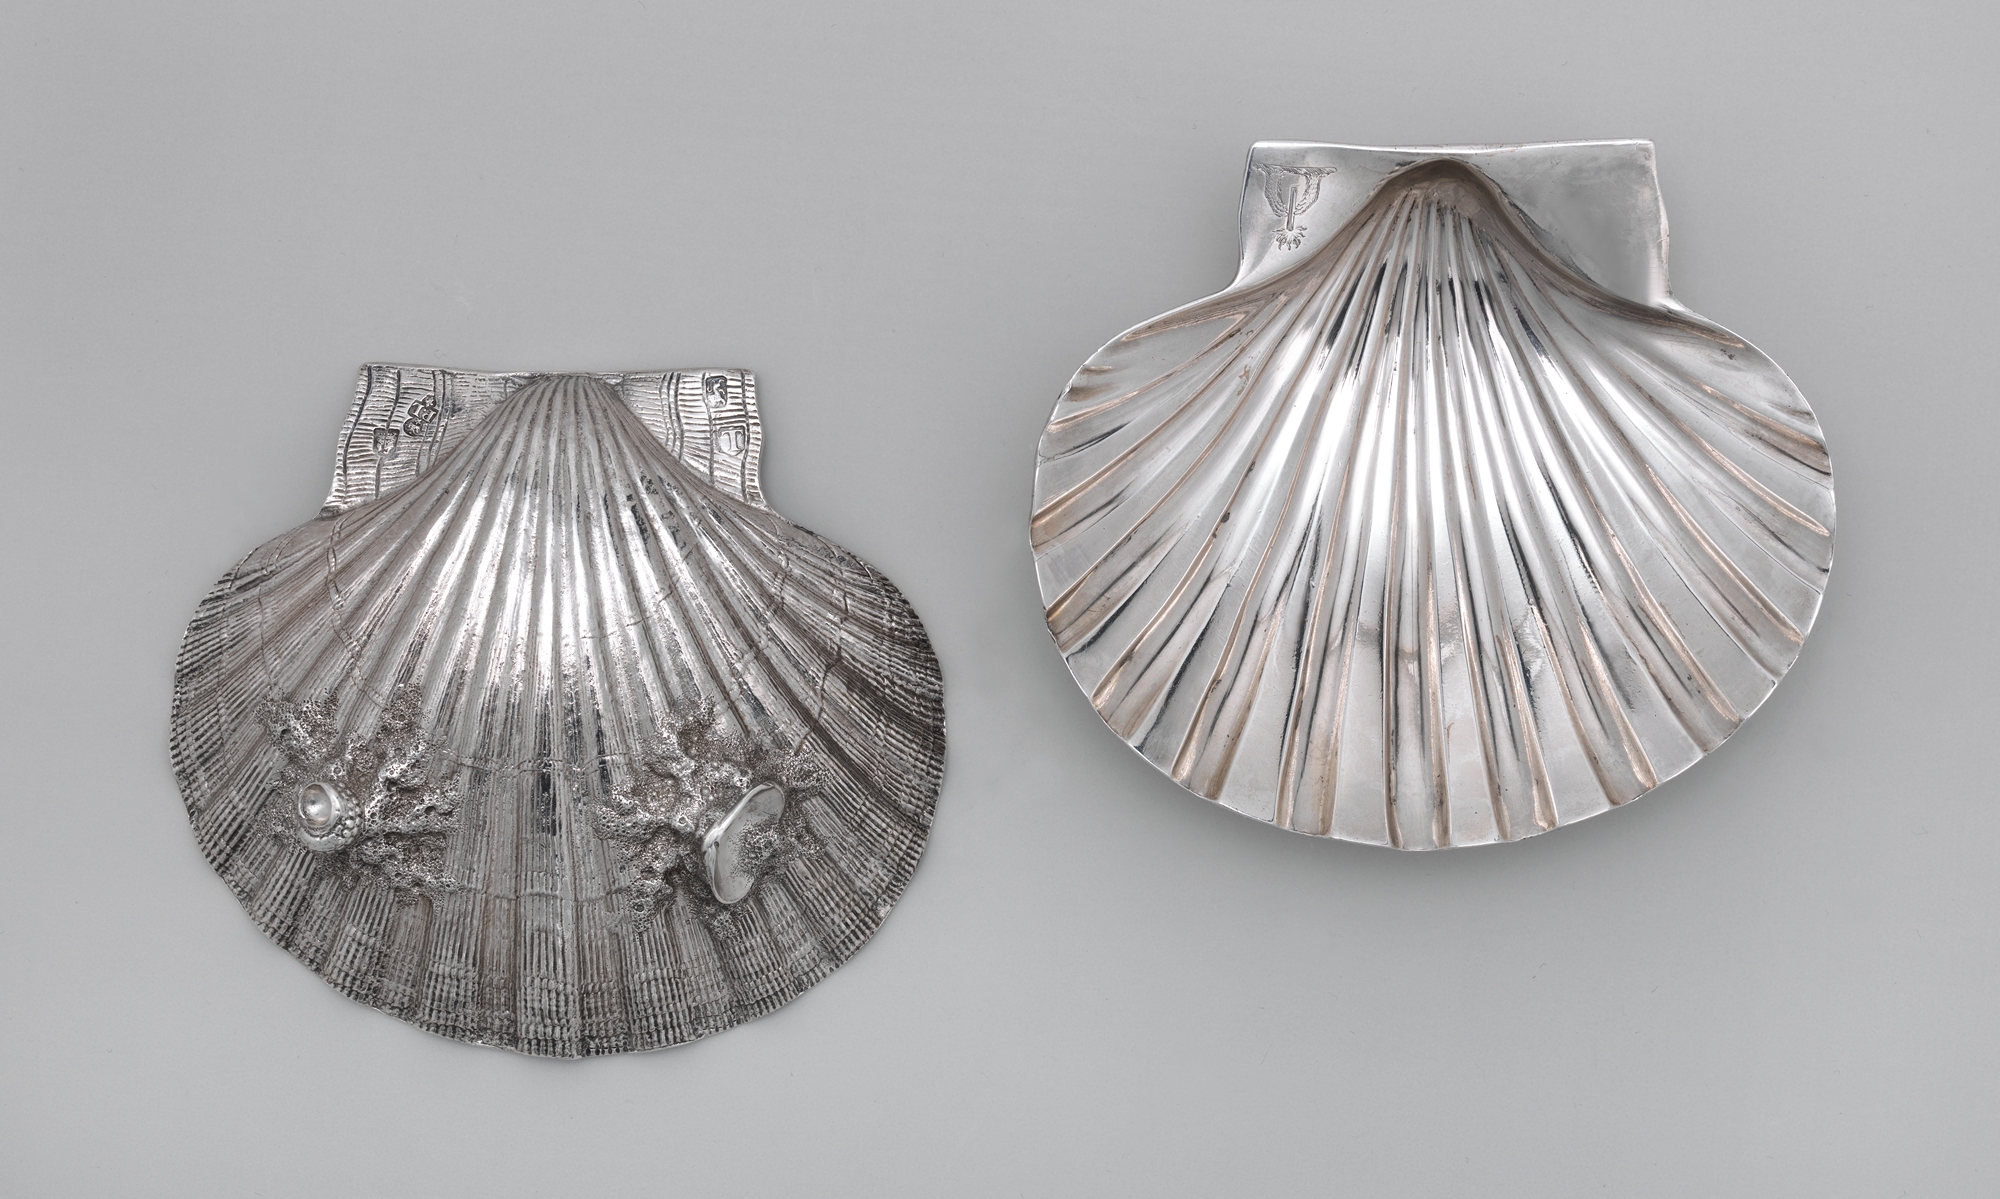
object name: scallop shell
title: Pair of scallop shells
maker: paul de lamerie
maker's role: maker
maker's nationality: british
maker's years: 1688-1751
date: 1734-1735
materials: silver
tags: shells